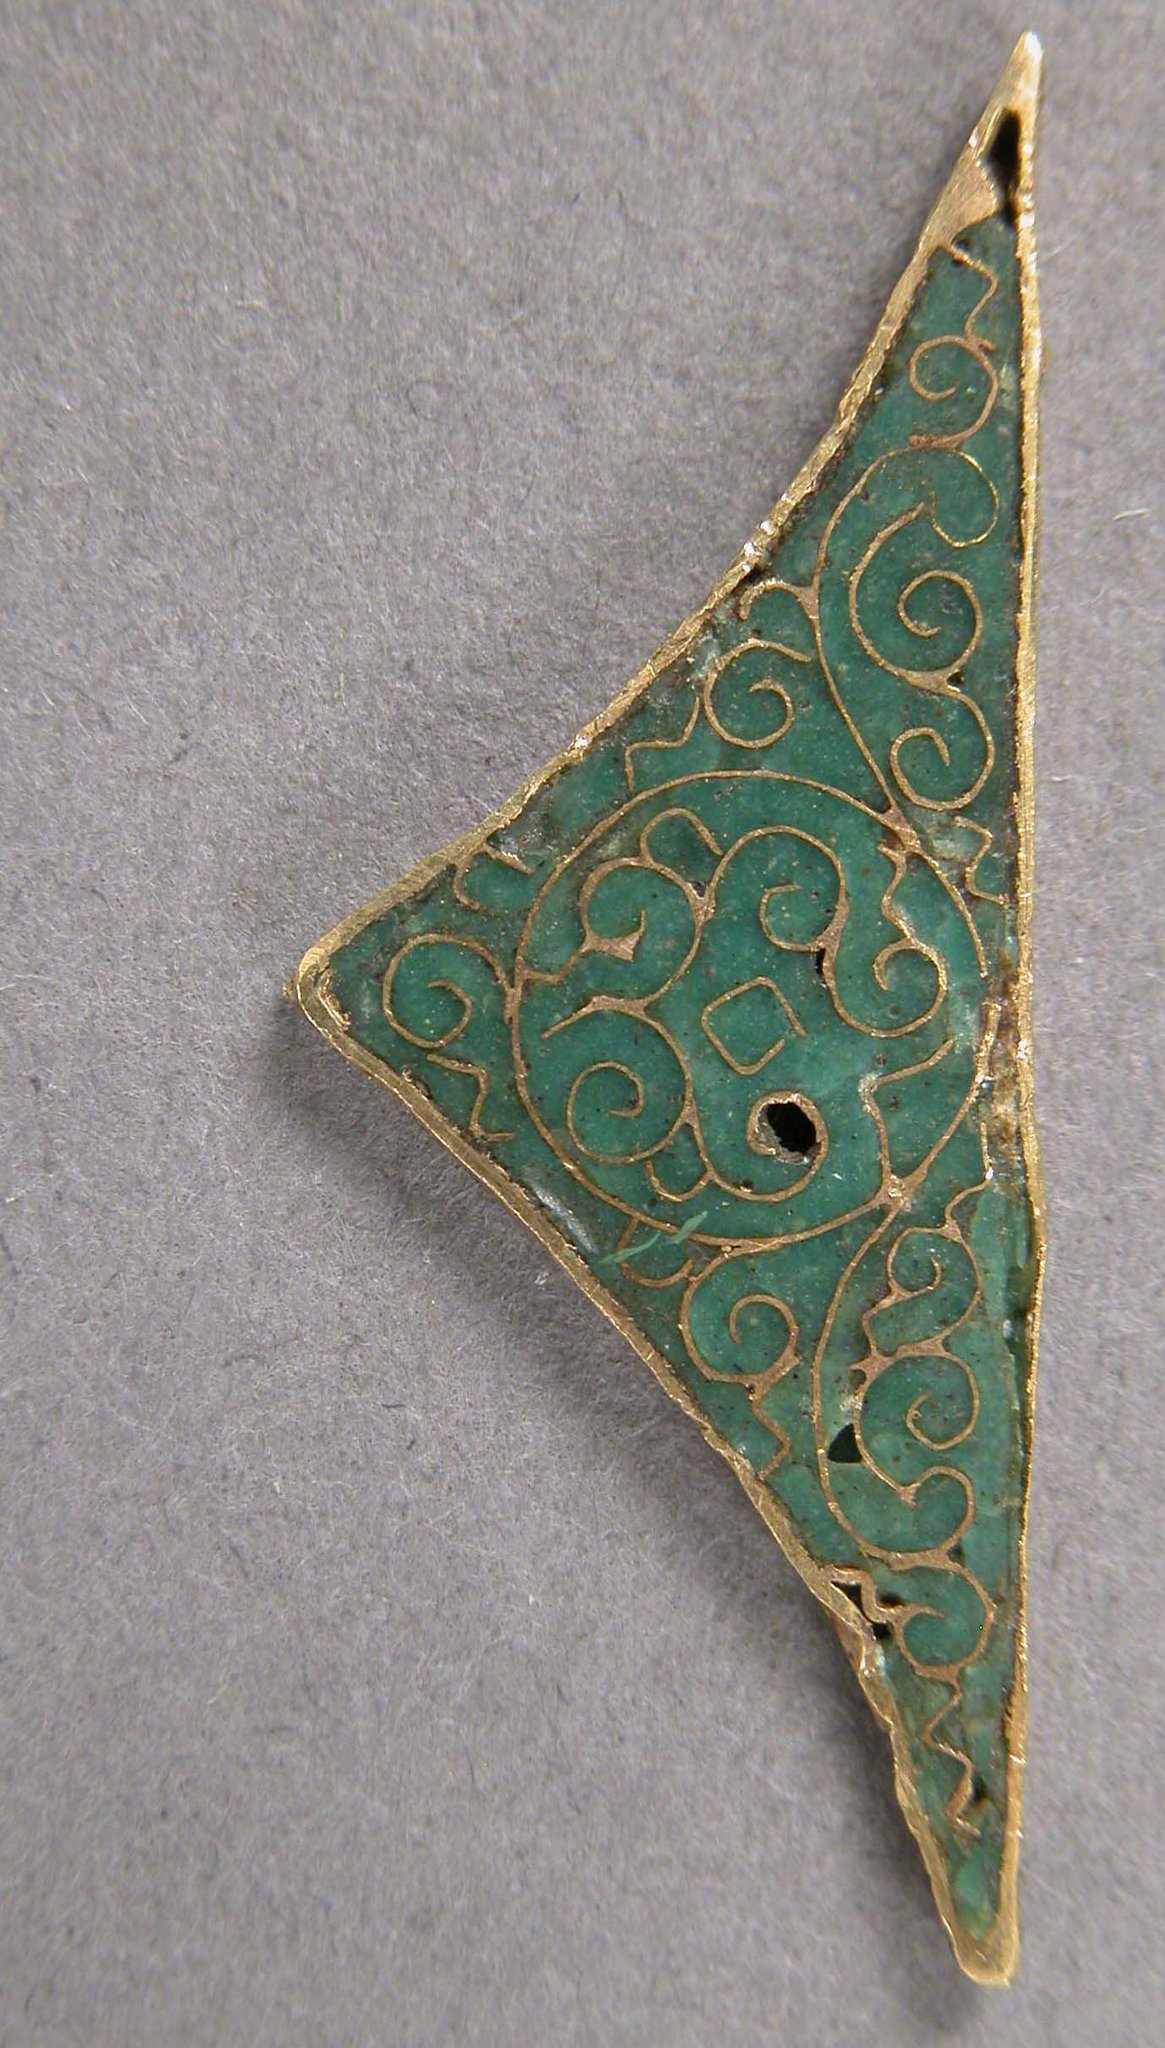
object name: enamel fragment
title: Element of an Icon Frame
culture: byzantine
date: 1001-1100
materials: copper, enamel, gold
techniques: enamel